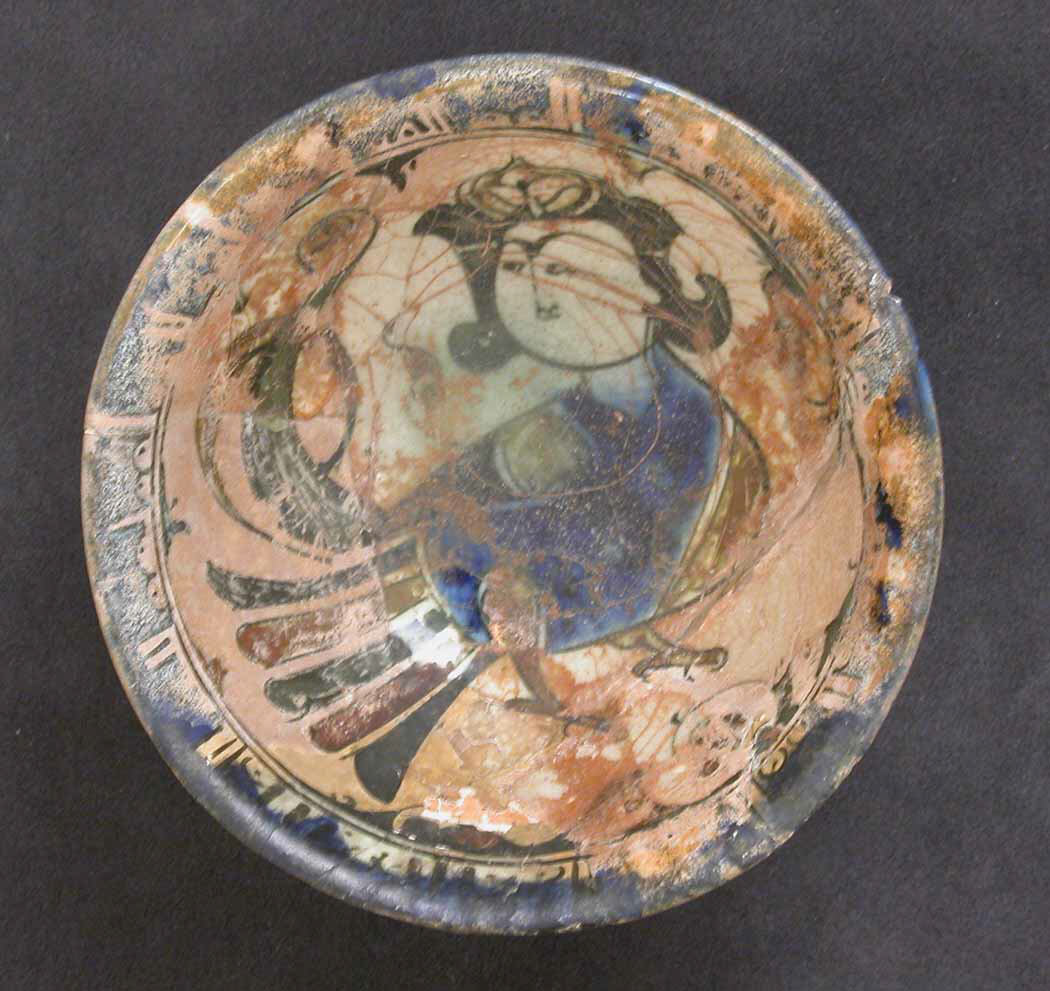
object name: bowl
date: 1101-1300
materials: stonepaste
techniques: painting, underglaze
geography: syria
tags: mythical creatures